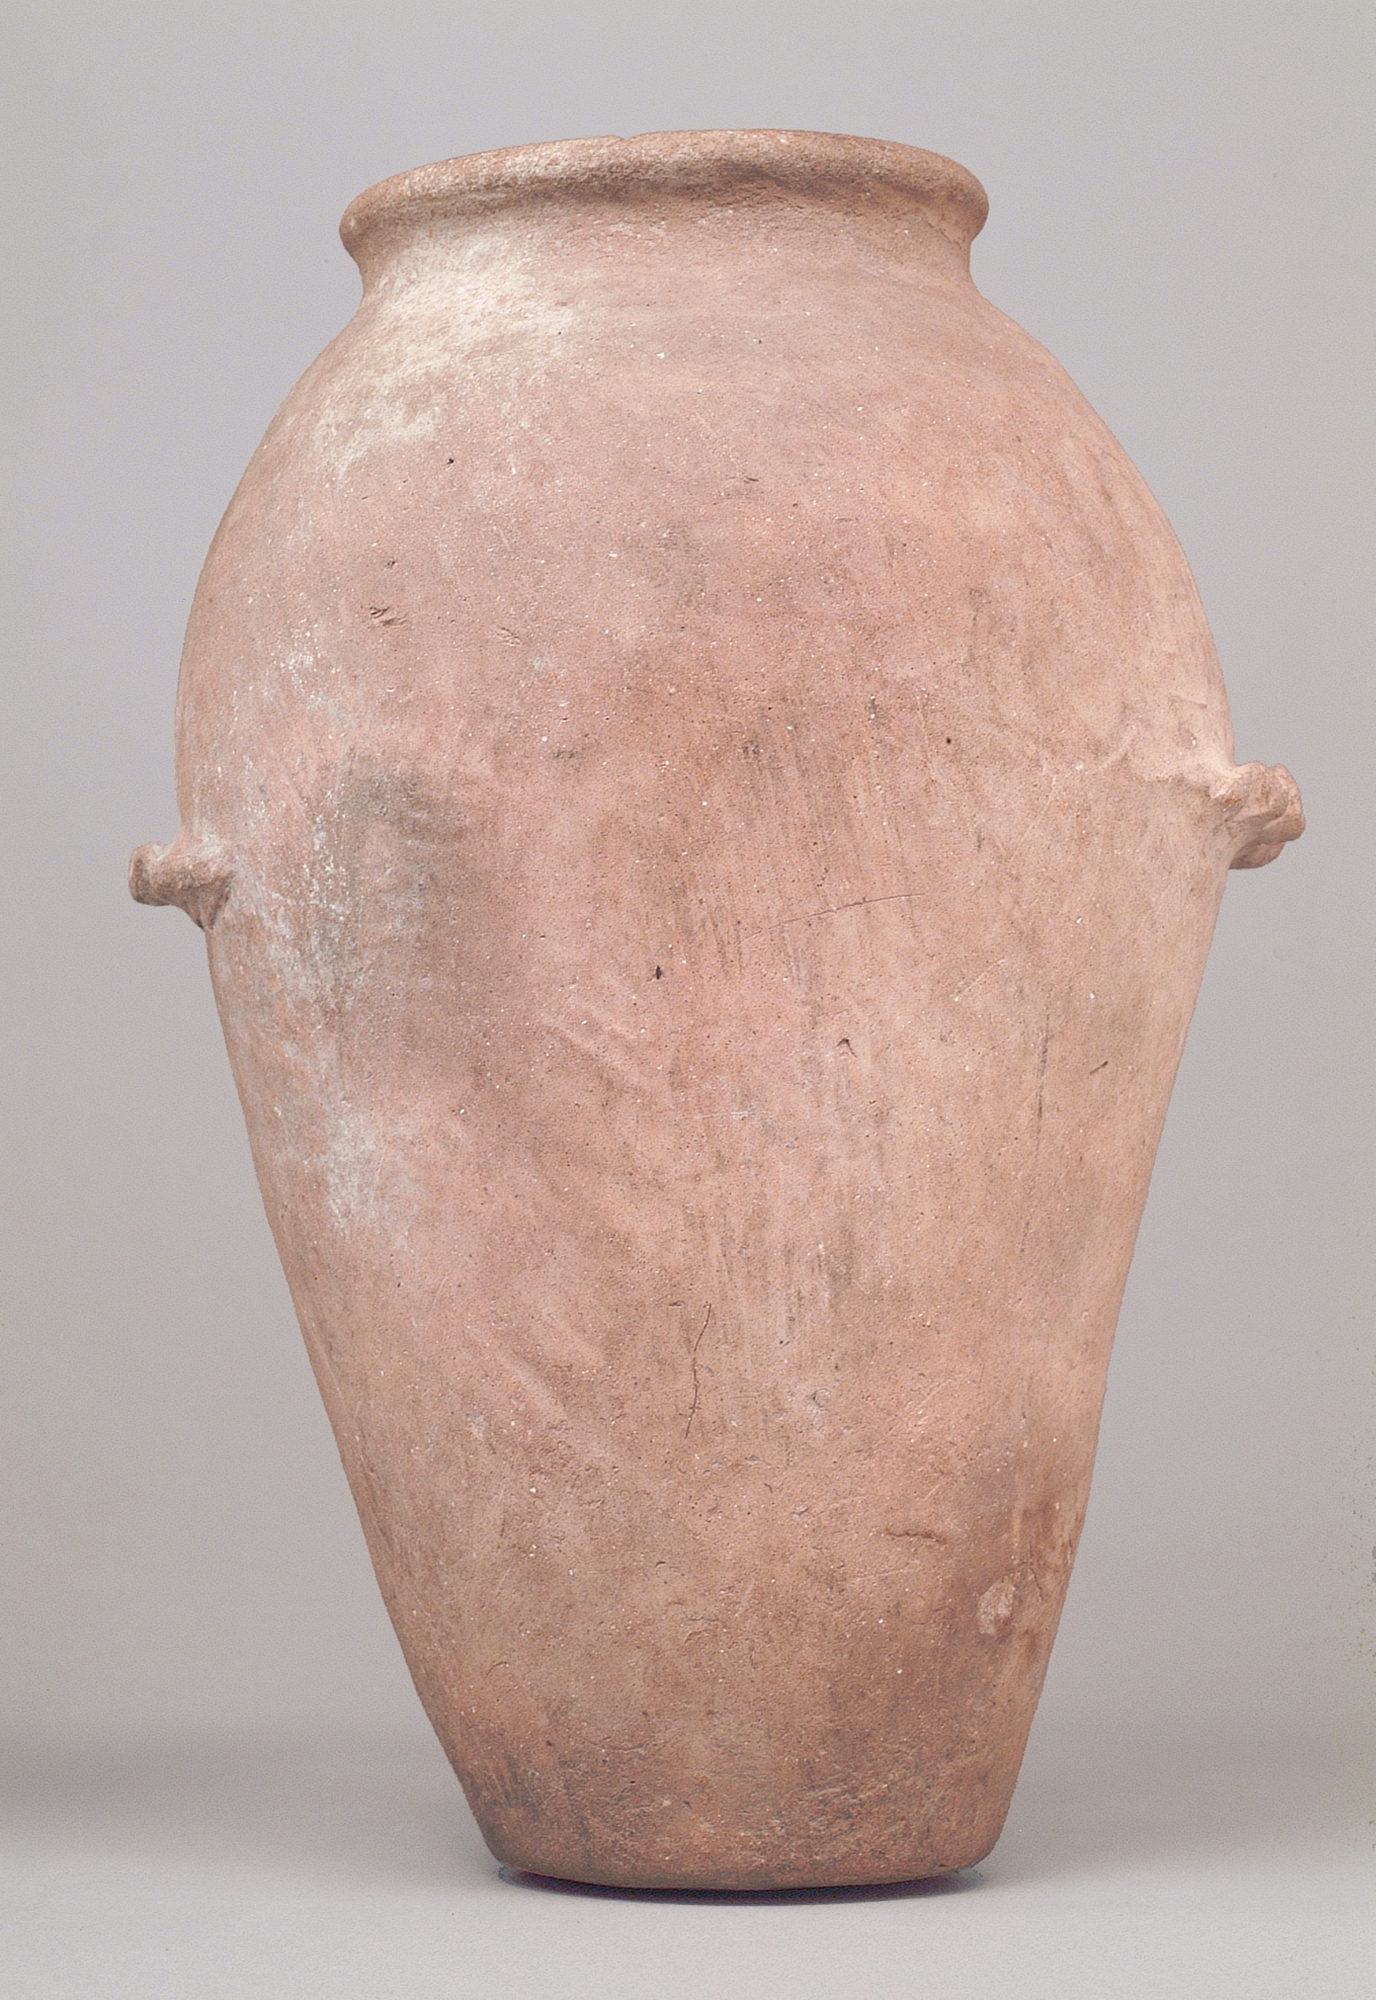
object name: jar, wavy handled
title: Wavy-handled jar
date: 3500-3300 BCE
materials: pottery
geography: egypt